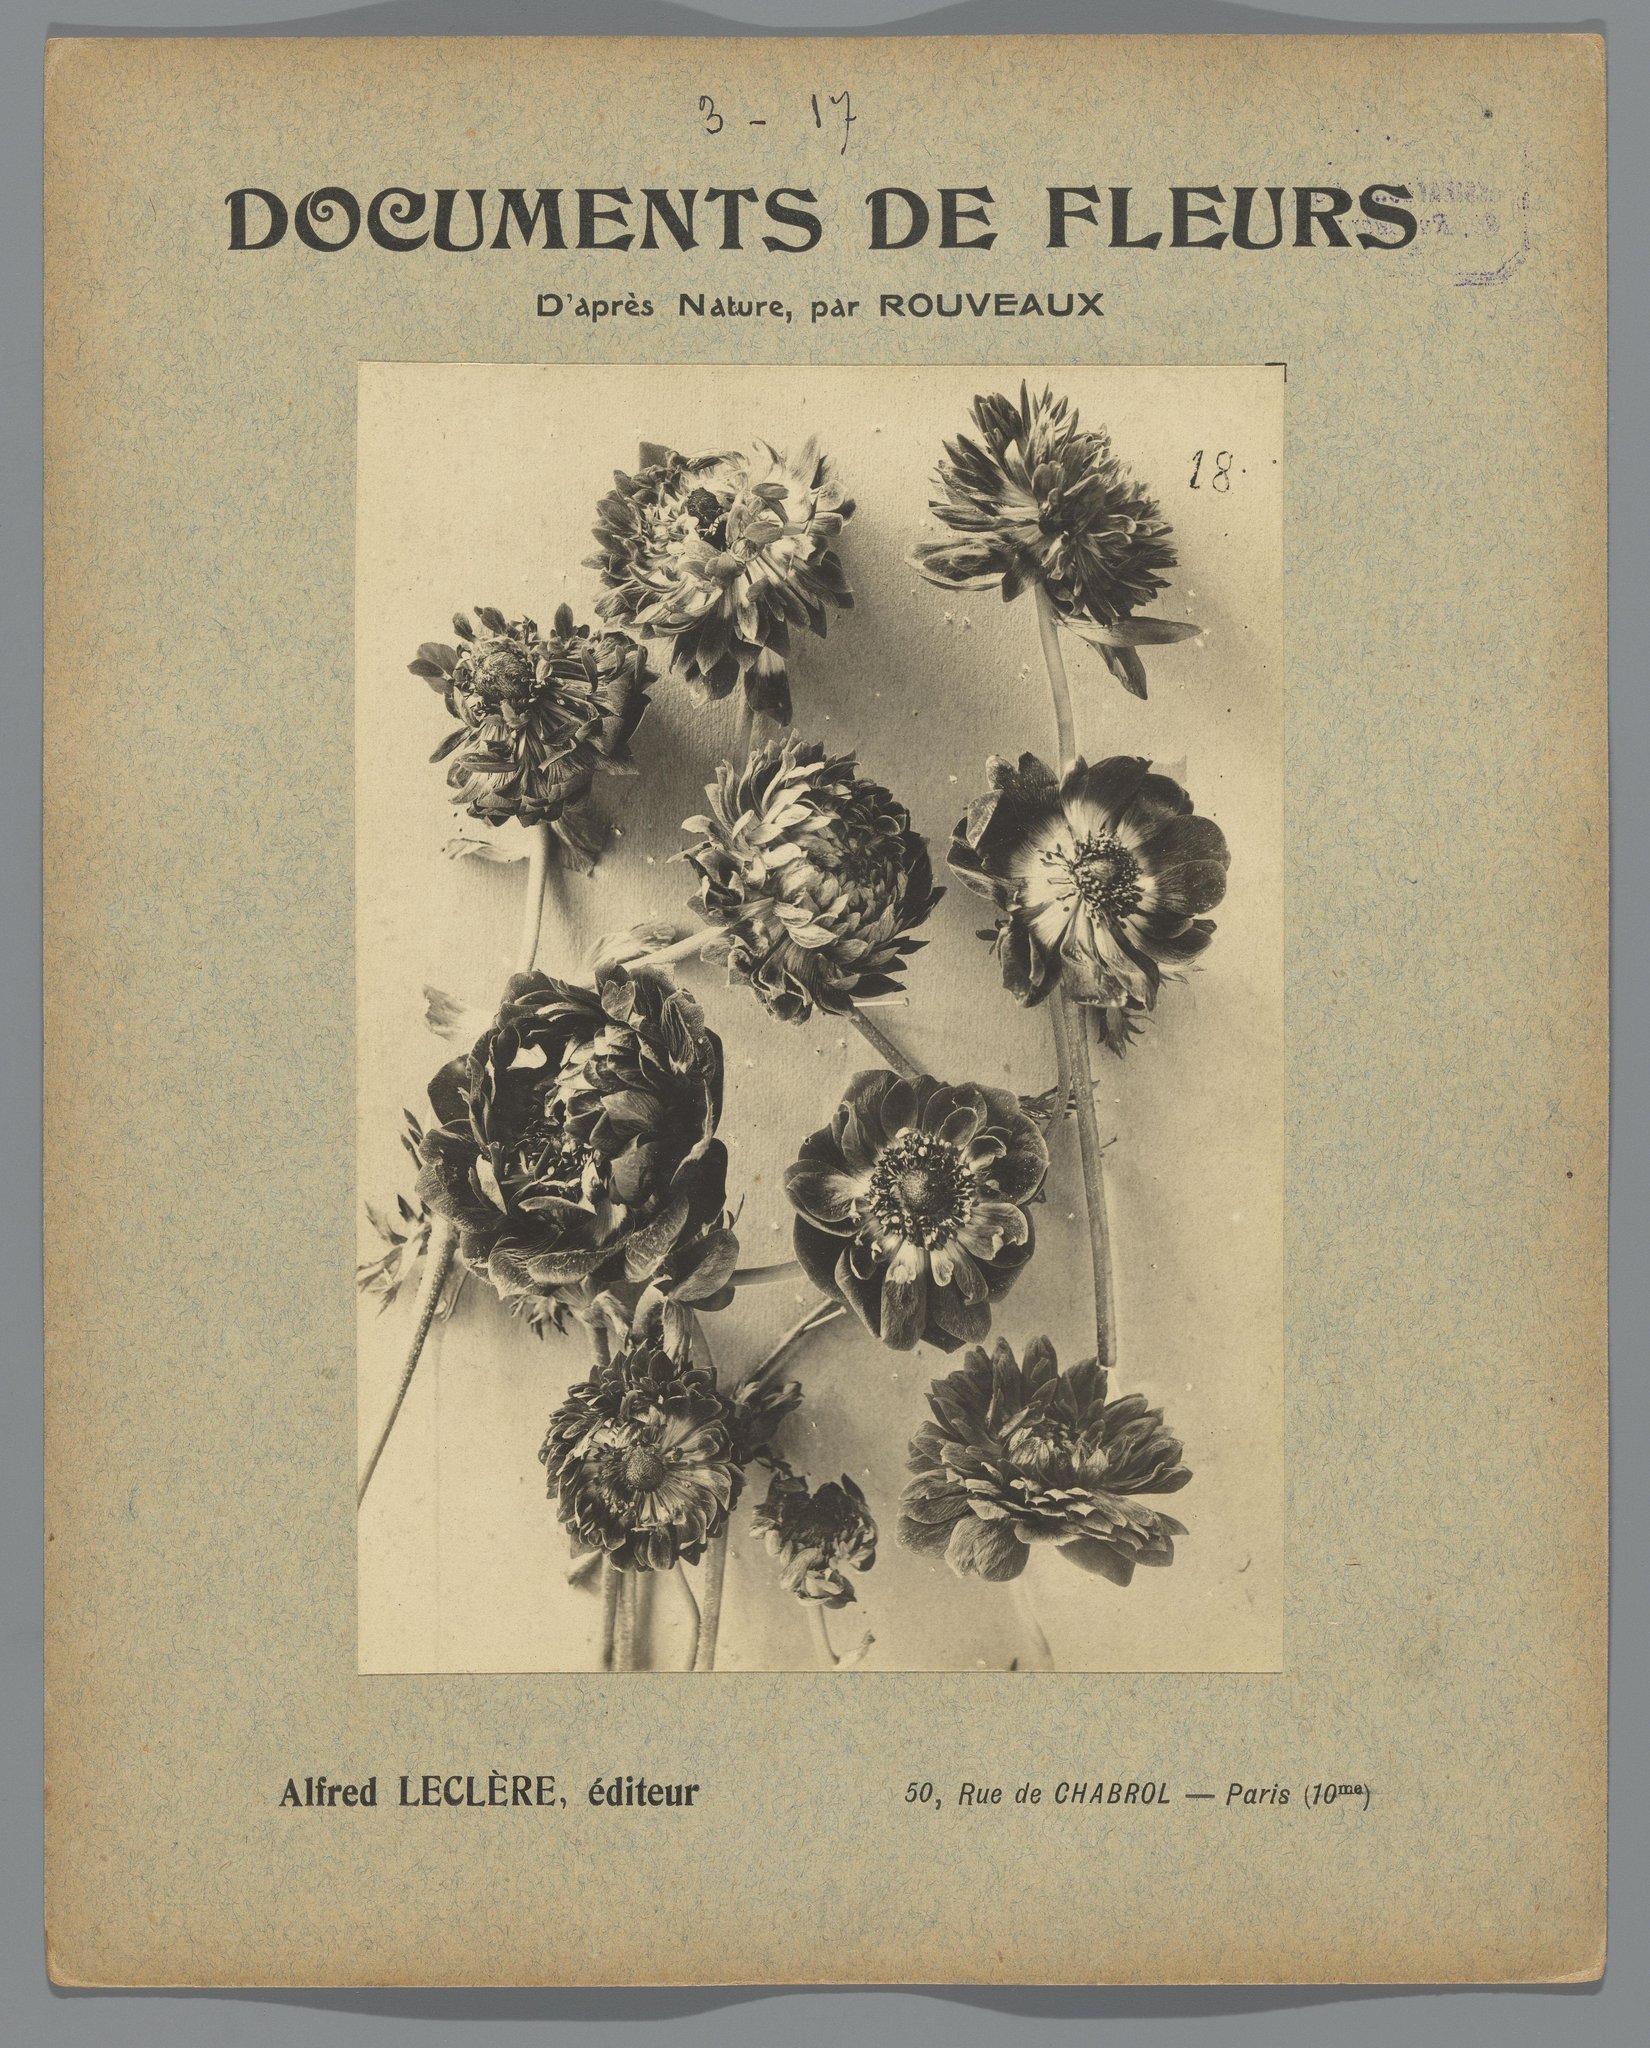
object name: photograph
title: Bloemstudie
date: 1895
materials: photographic support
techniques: gelatin silver print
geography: france